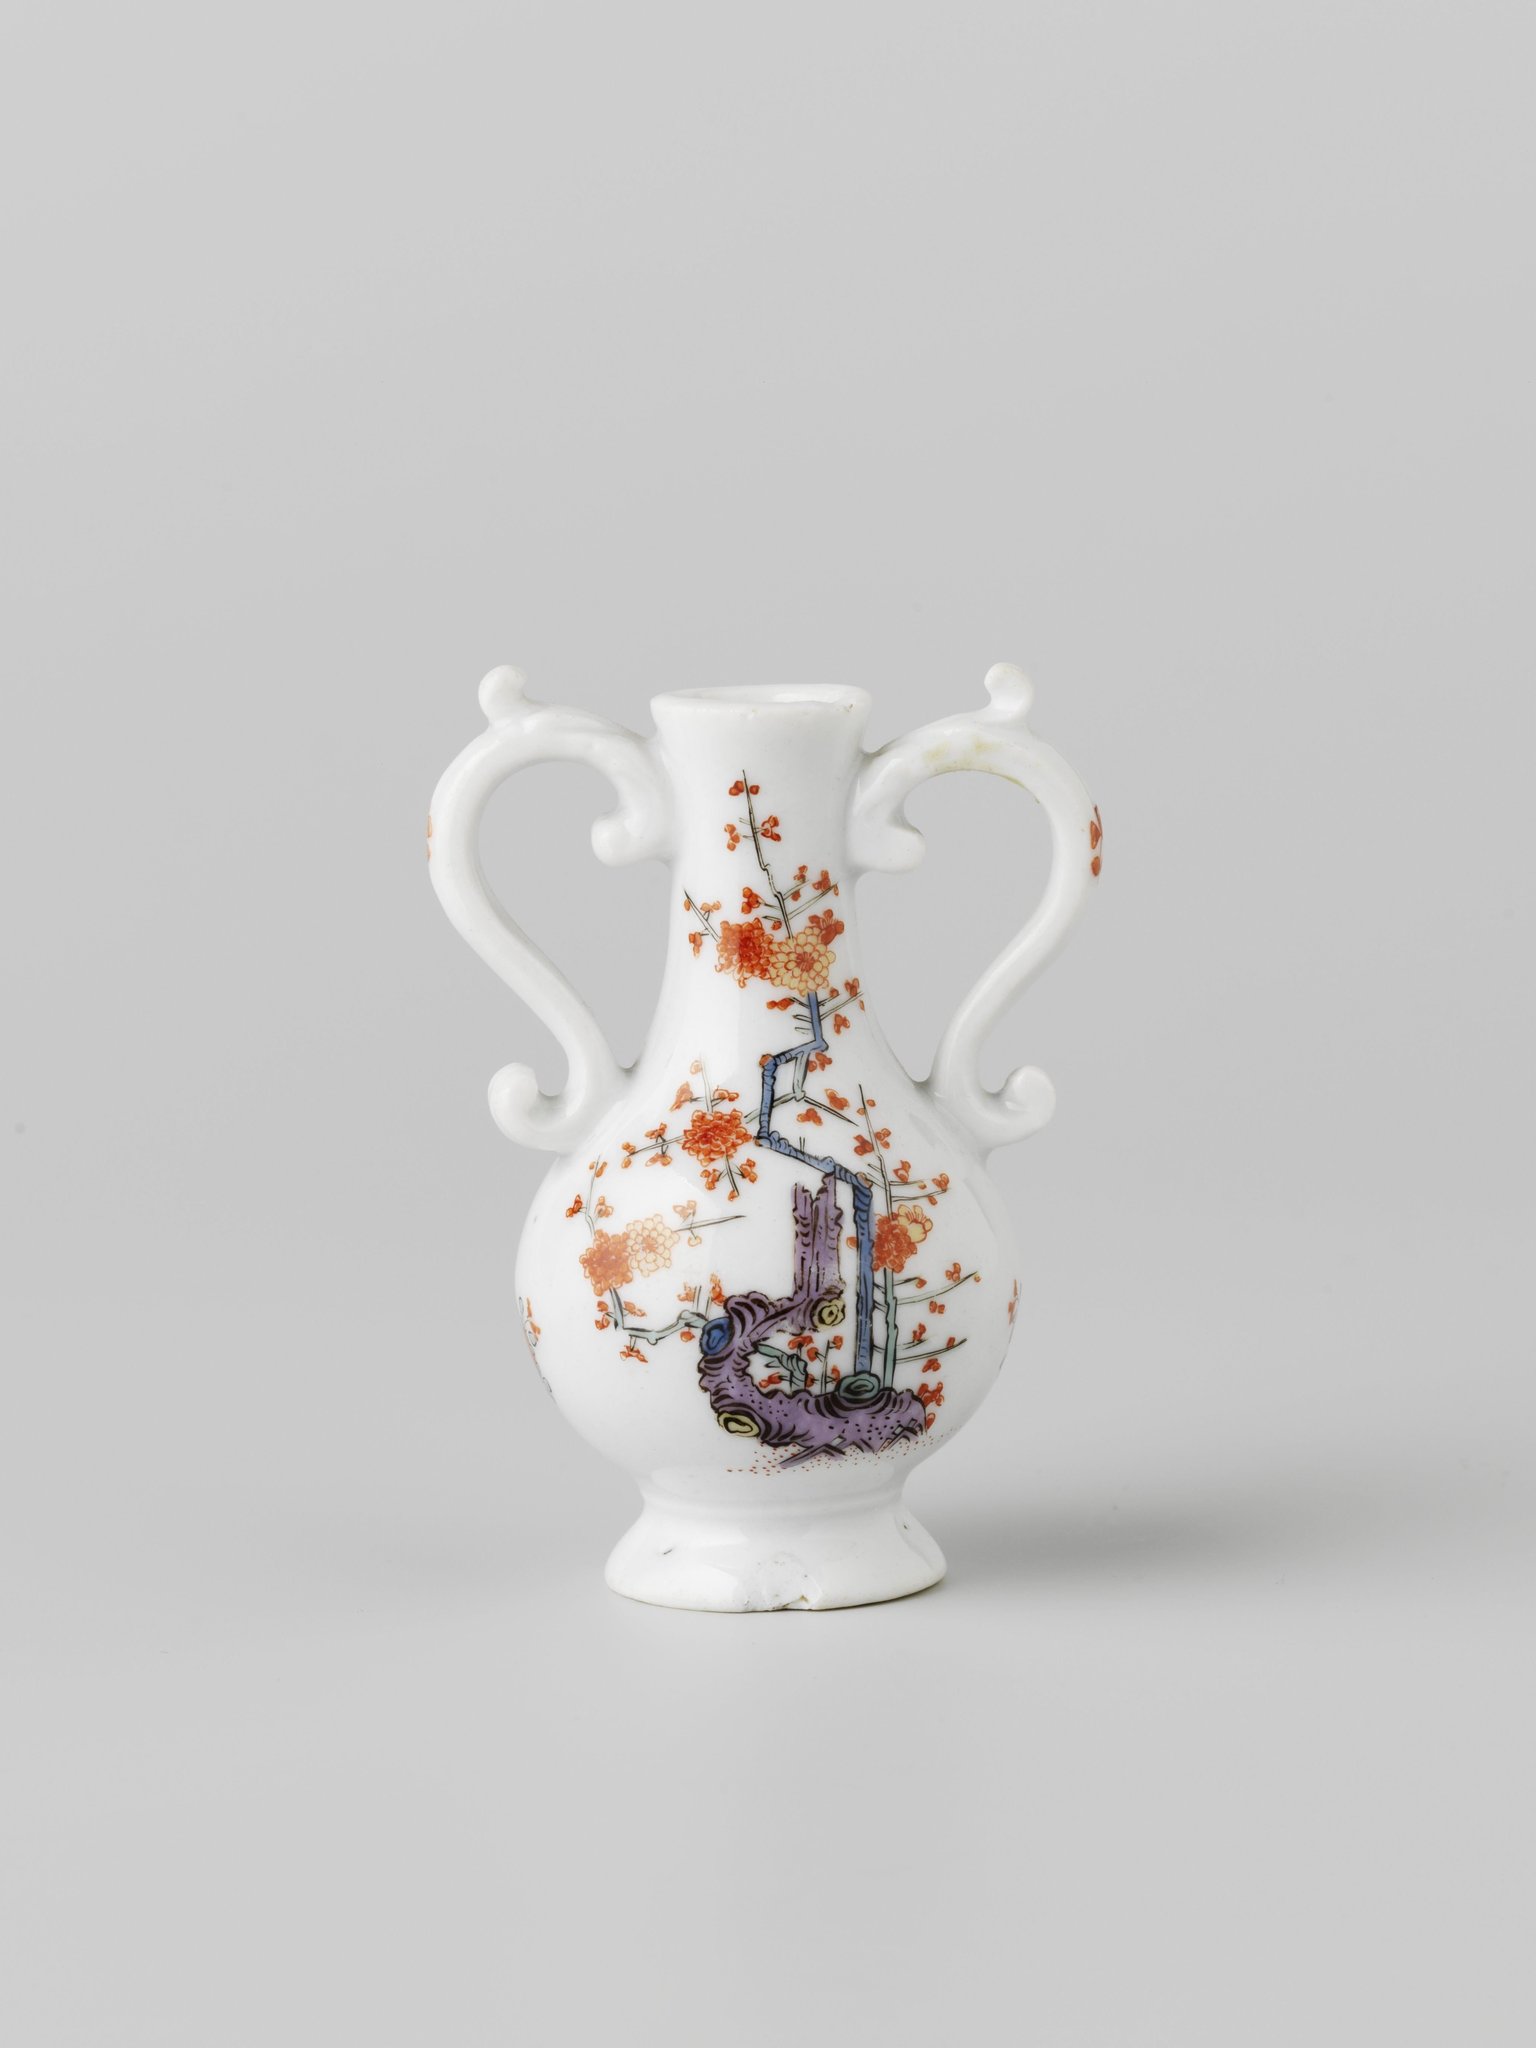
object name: bottle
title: Fles met twee oren, veelkleurig beschilderd met een Kakiemon-decor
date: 1735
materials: porcelain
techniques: painted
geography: meissen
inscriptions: factory mark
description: Two miniature vases. Meissen, c. 1730 - 1740.